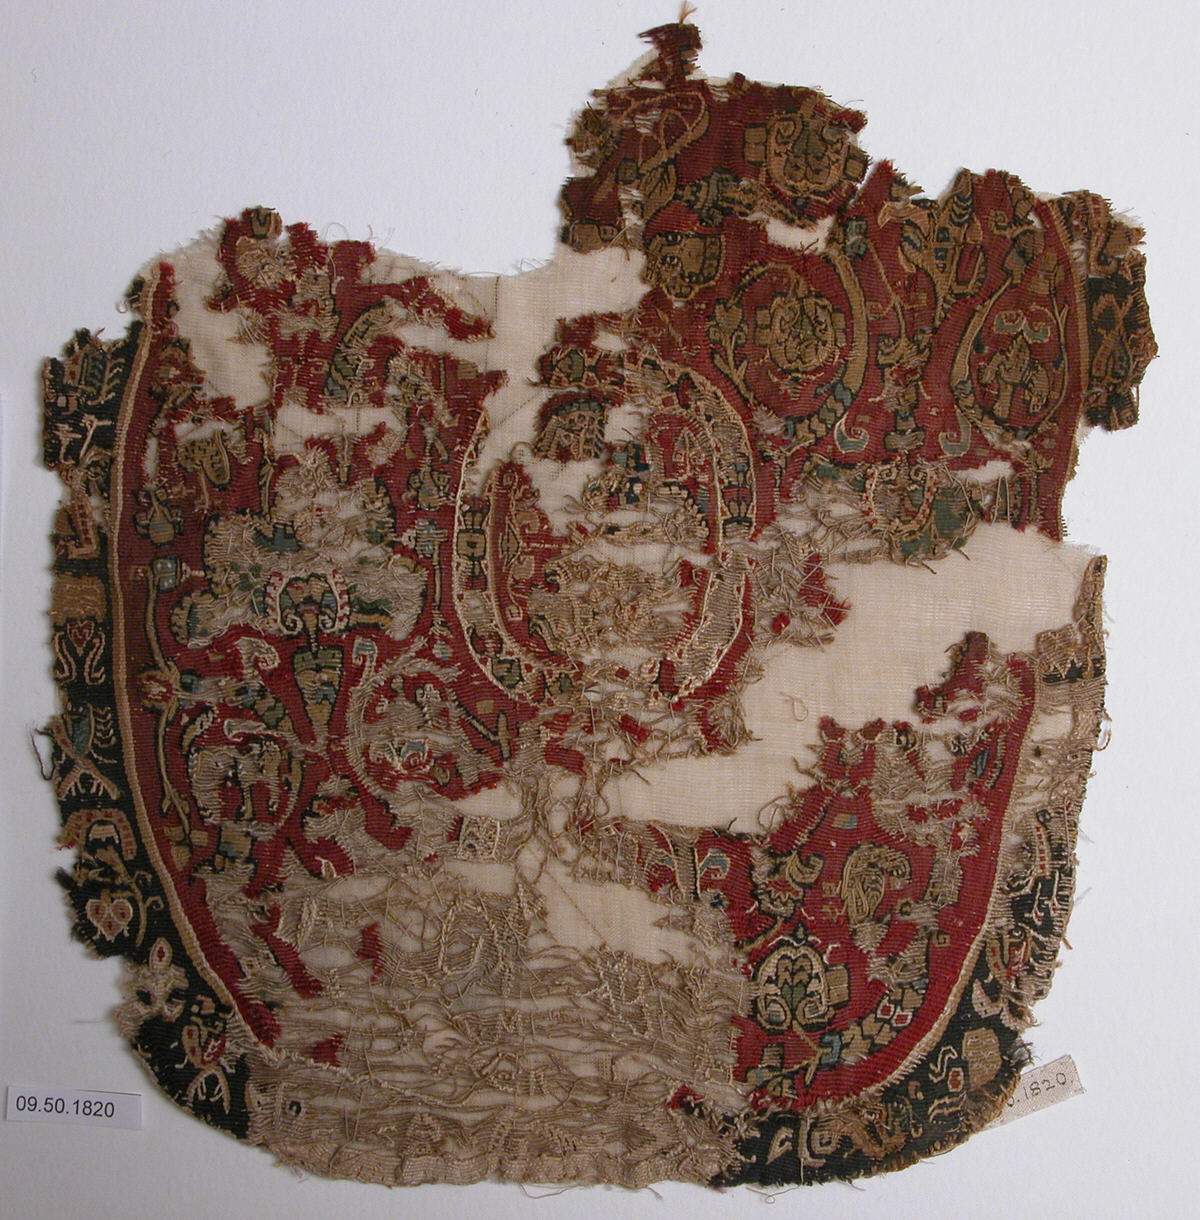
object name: roundel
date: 601-800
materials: linen, wool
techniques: weave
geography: egypt